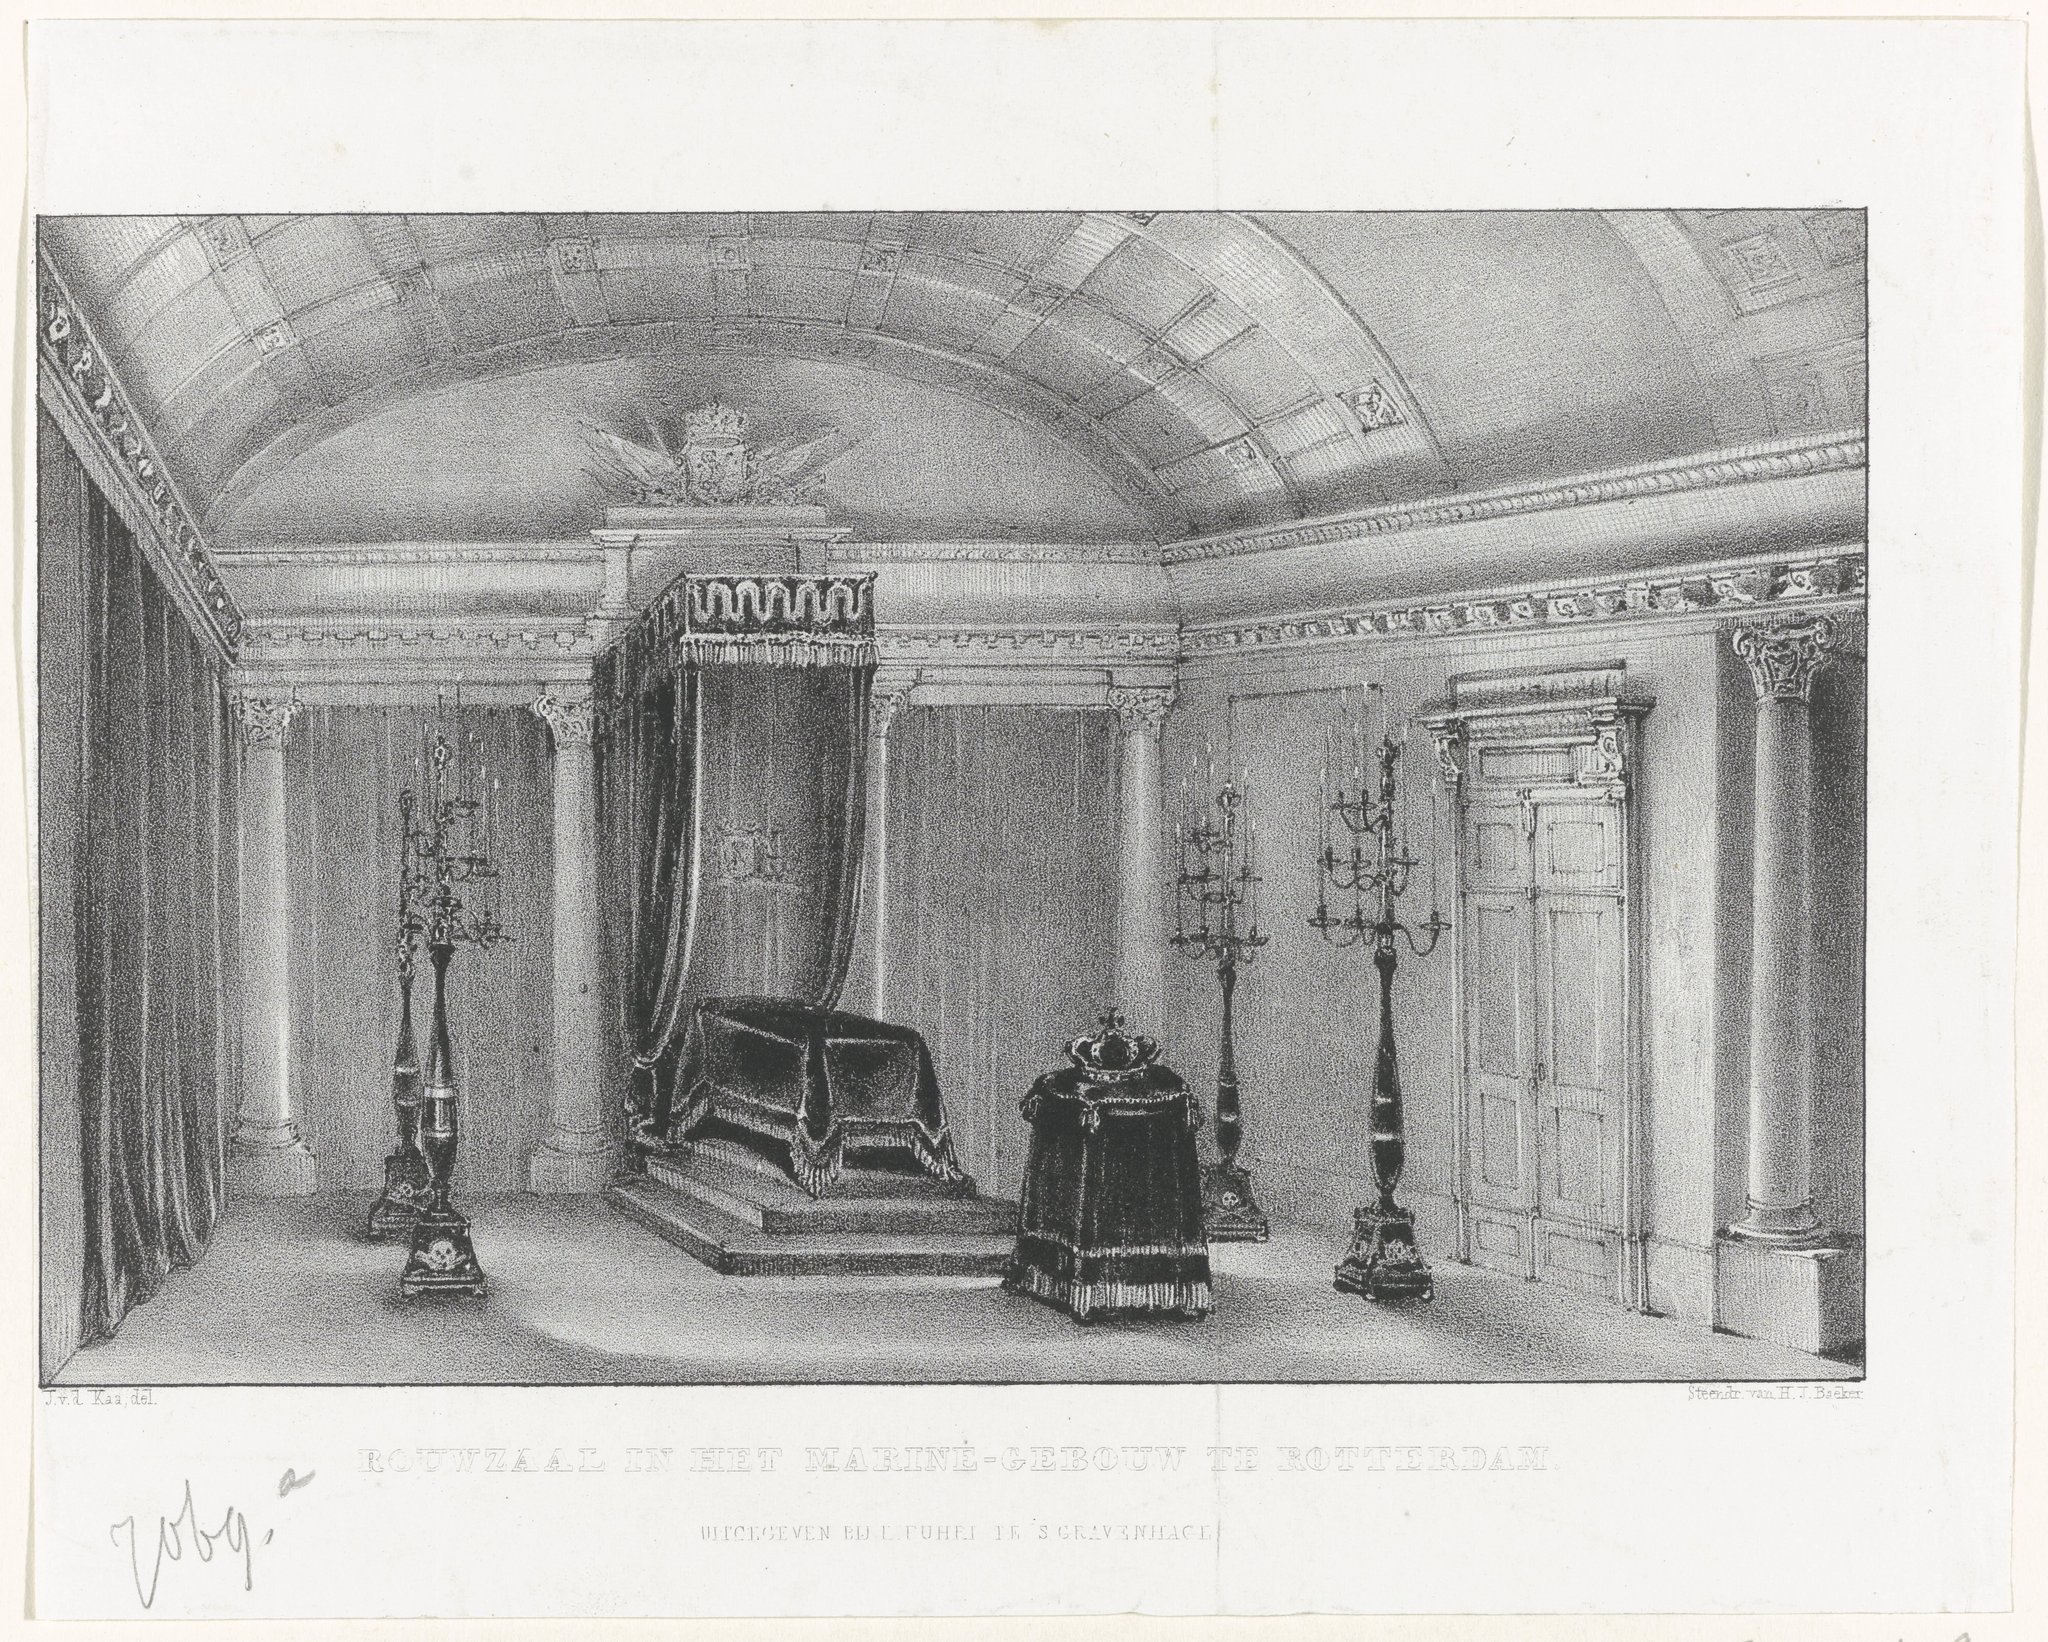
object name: print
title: Rouwzaal met de lijkkist en regalia van koning Willem I, 1843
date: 1844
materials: paper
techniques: lithograph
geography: the hague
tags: the hague, berlin, william i of the netherlands, funerary ceremonial, lying in state, rotterdam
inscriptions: collector's mark: Lugt 2228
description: Gebruikt als illustratie in: Friedrich Ehrenberg, Levensschets van Zijne Majesteit Koning Willem Frederik, graaf van Nassau : gevolgd door eene naauwkeurige beschrijving der plegtigheden van Zijner Majesteit's begrafenis, en de lijkrede, bij de plegtige inzegening van het lijk te Berlijn. 's-Gravenhage: K. Fuhri, 1844.